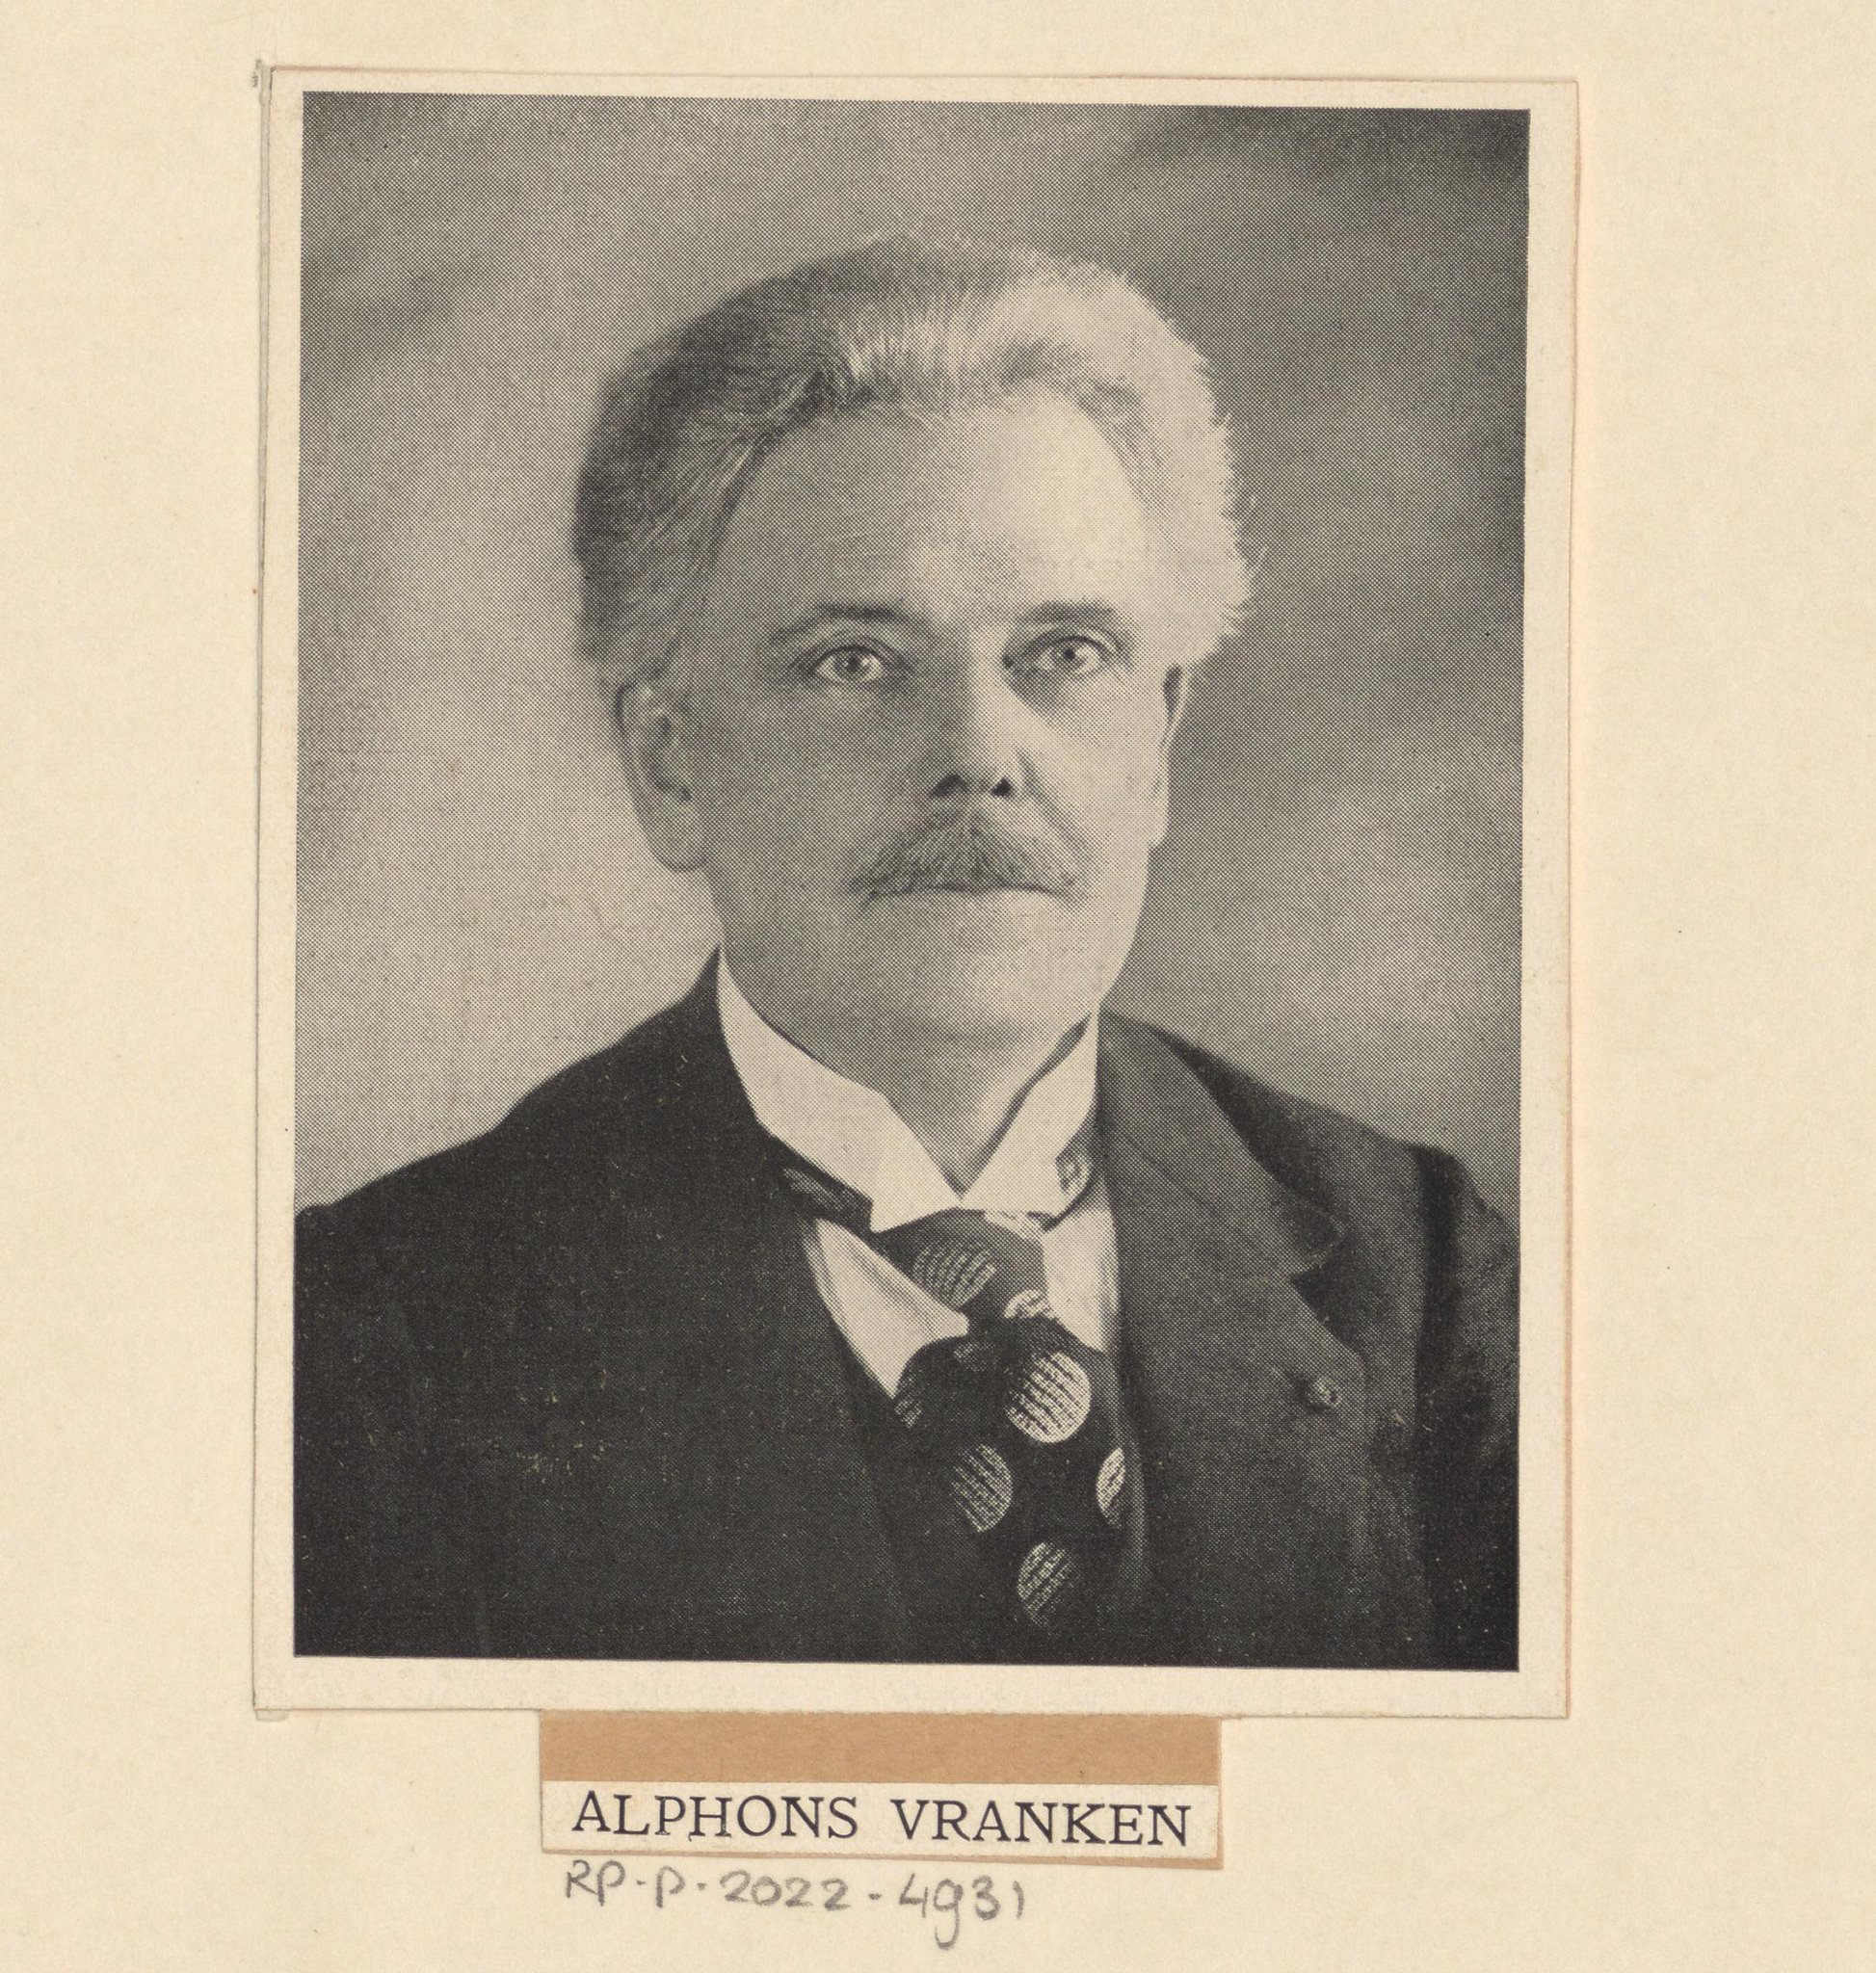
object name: photomechanical print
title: Portret van Alphons Vranken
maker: Anonymous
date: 1940-1953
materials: paper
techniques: autotype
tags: historical persons, portrait of composer